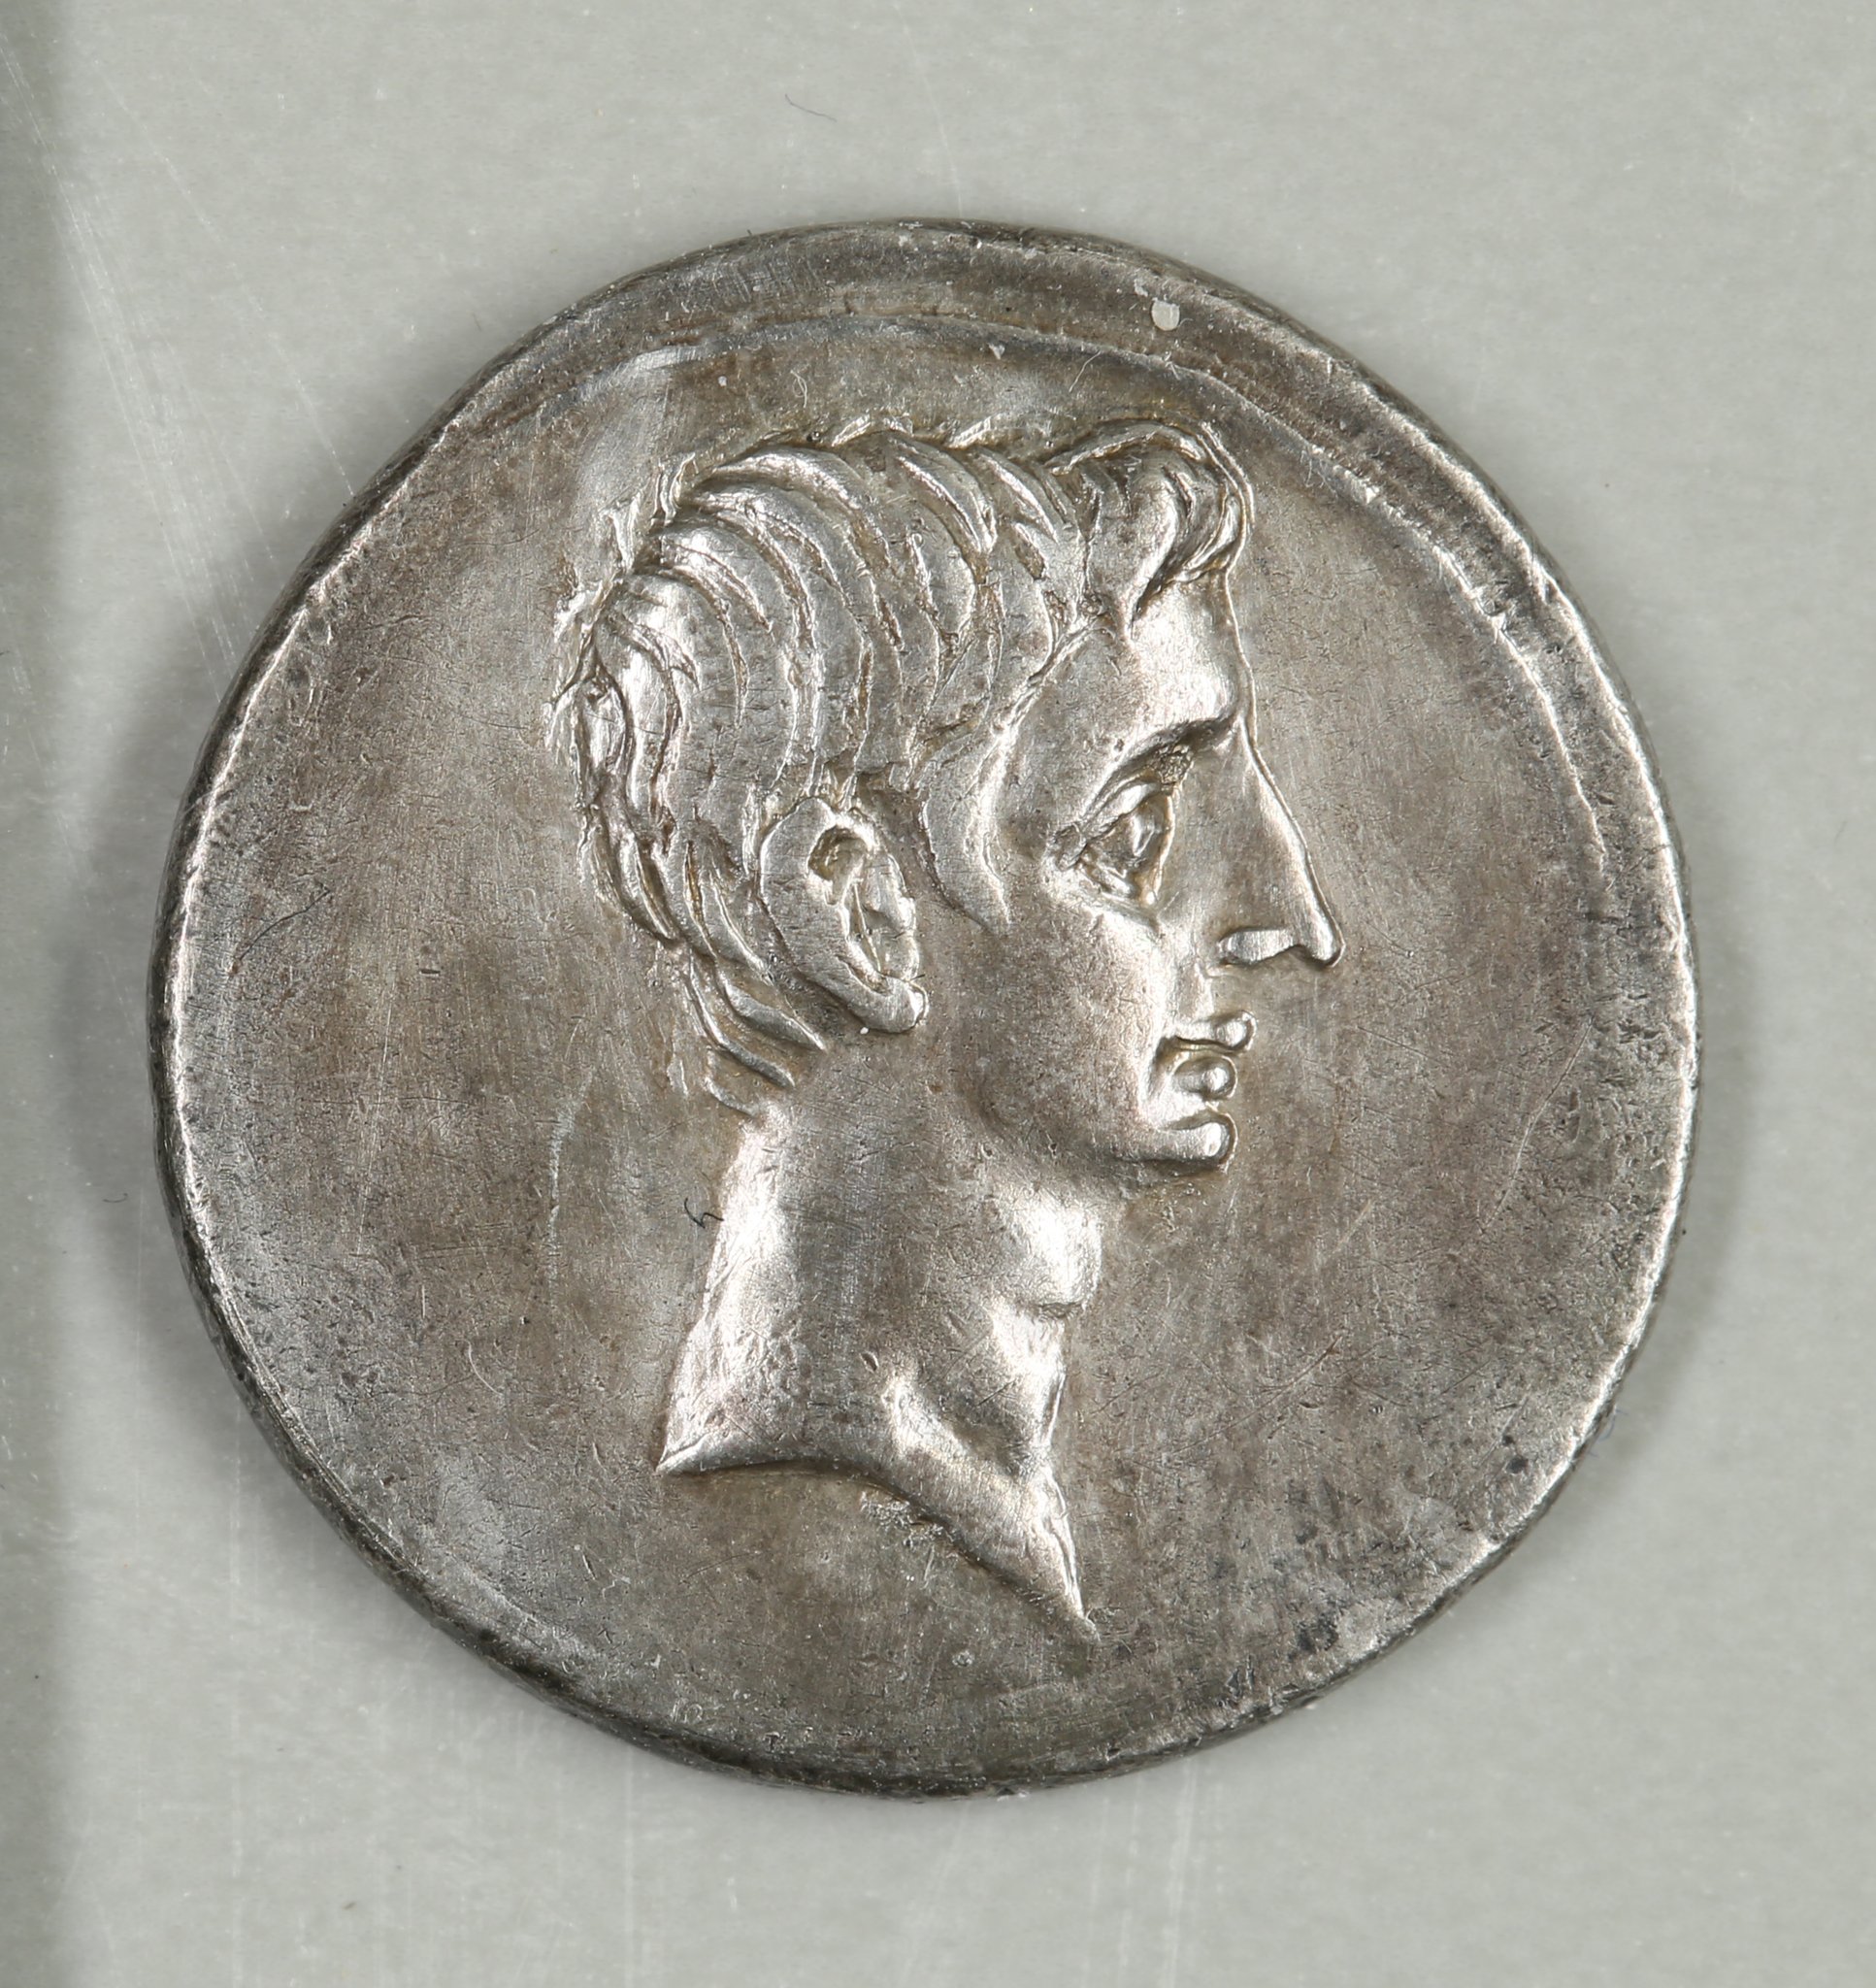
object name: denarius of octavian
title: Silver denarius of Octavian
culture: roman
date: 29-27 BCE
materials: silver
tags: men,profiles,horses